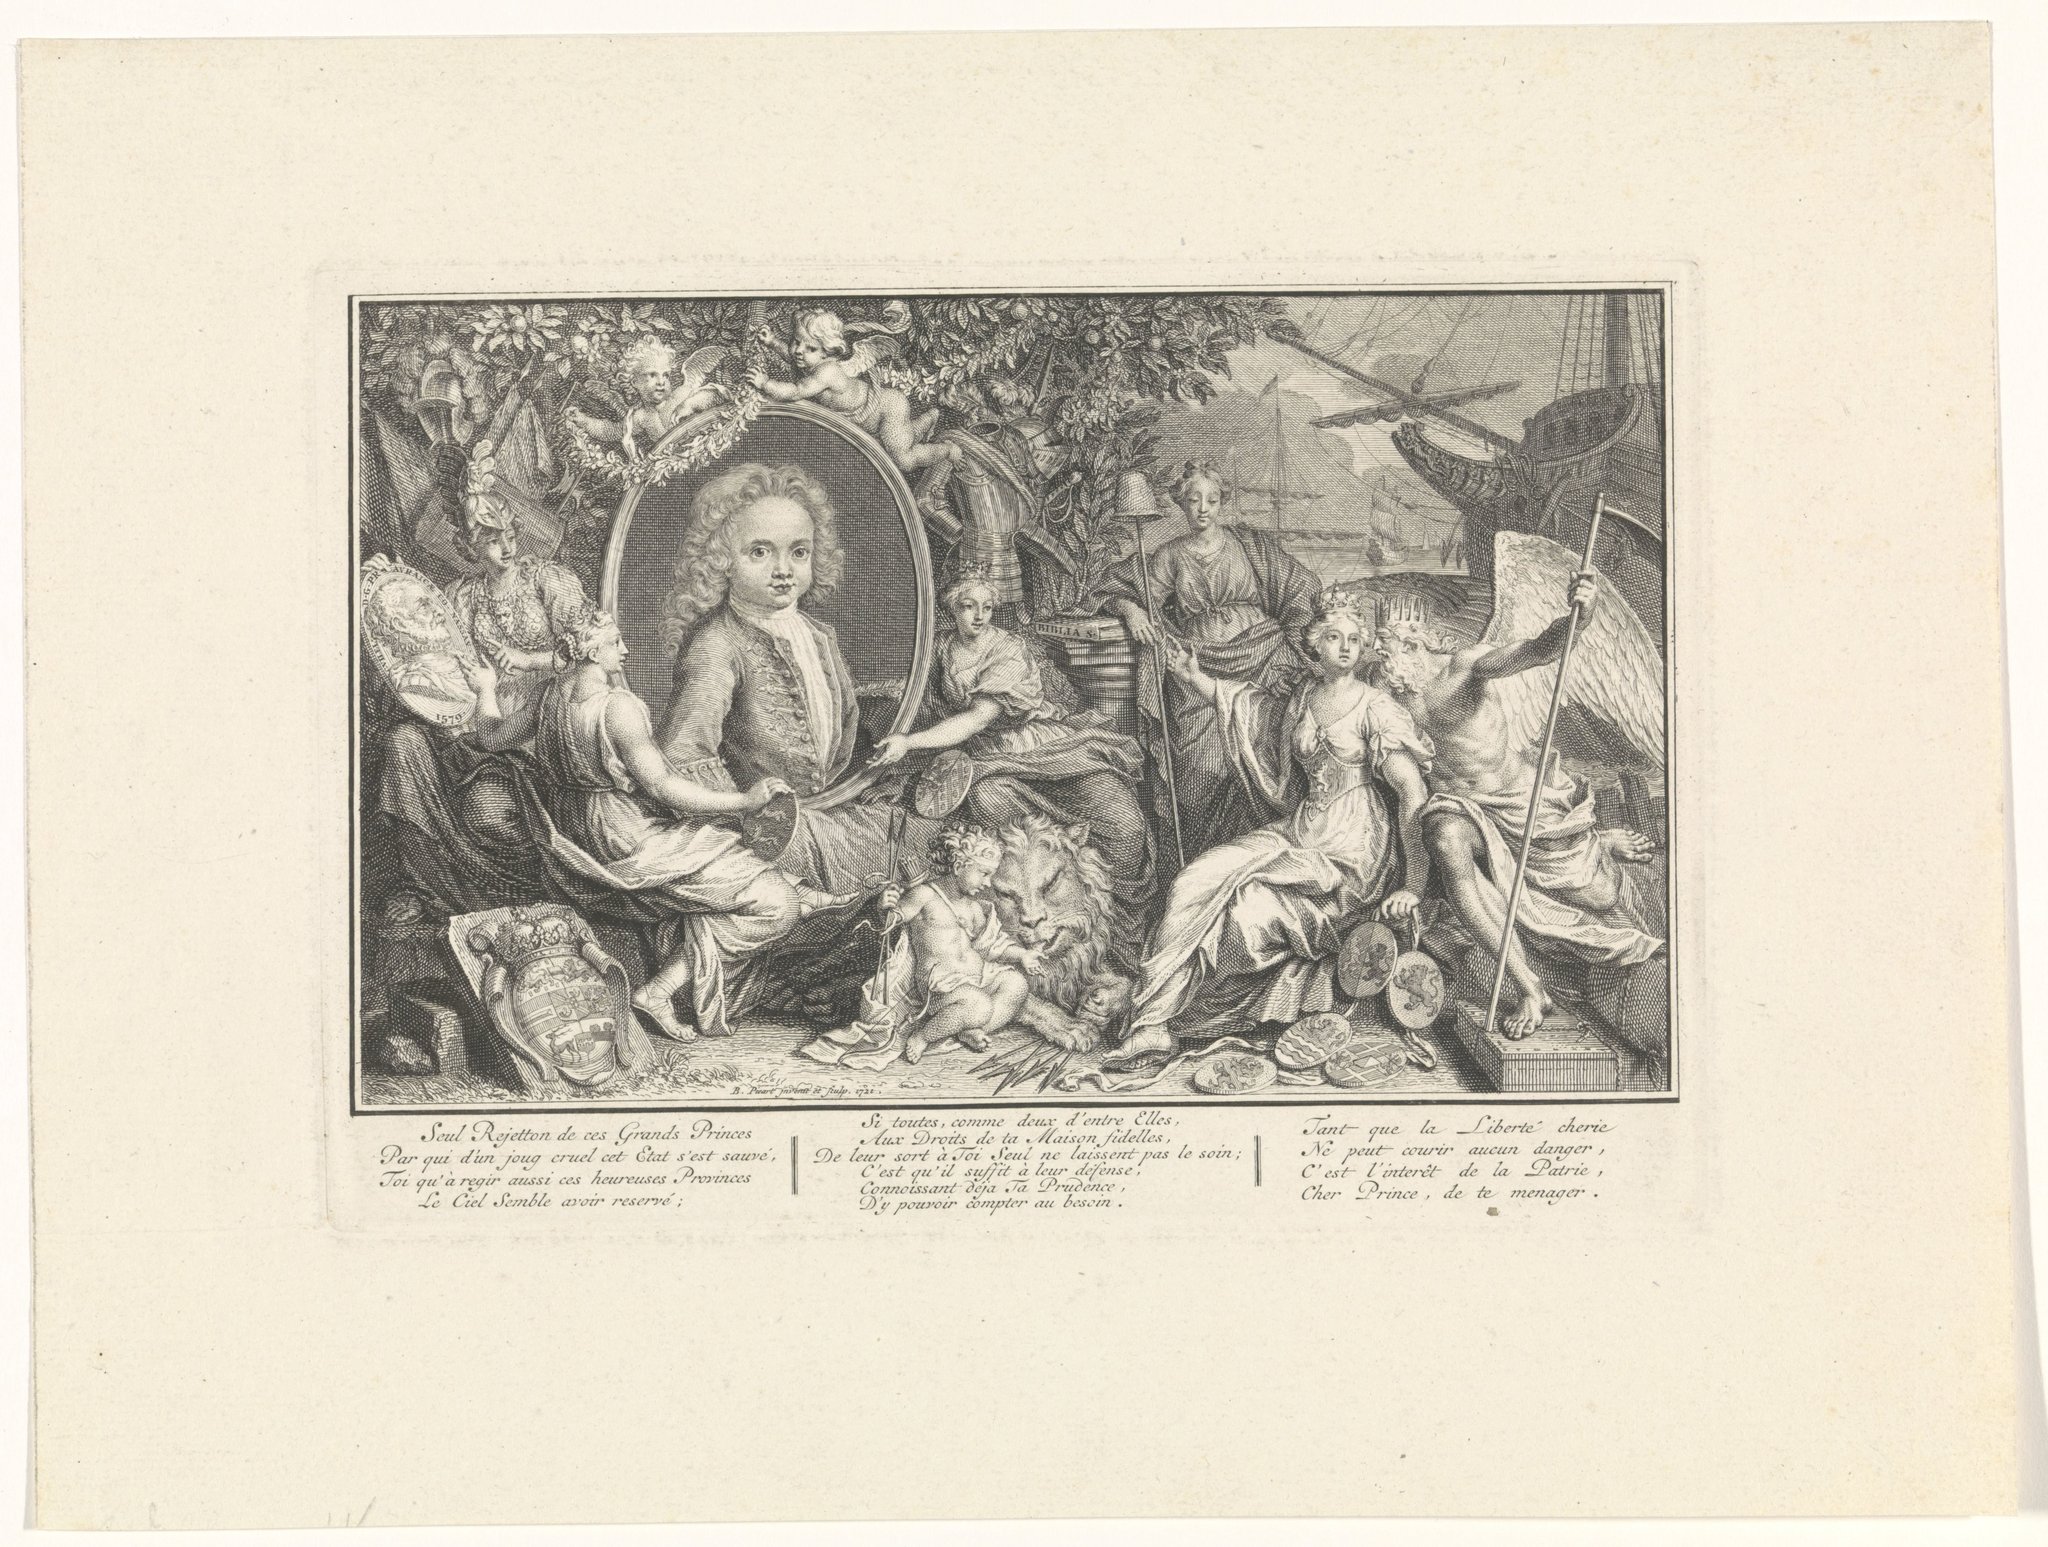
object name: print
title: Allegorie met het portret van Willem IV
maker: bernard picart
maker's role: draughtsman, print maker, publisher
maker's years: 1673-1733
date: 1721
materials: paper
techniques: engraving, etching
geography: amsterdam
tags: delft, william i (prince of orange), the hague, willem iv (prins van oranje-nassau), coat of arms (symbol of sovereignty), personifications of countries, nations, states, districts, etc., symbols, allegories of peace, 'pax'; 'pace' (ripa), (story of) minerva (pallas, athena), father time, man with wings and scythe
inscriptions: collector's mark: Lugt 240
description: Allegorie met het portret van Willem IV op 10-jarige leeftijd, 1721. Twee provinciemaagden van Friesland en Groningen dragen het portretmedaillon. Rechts Vader Tijd en de Nederlandse Maagd. Links Minerva met een portret van prins Willem I. In de marge een onderschrift met een vers in drie kolommen in het Frans.